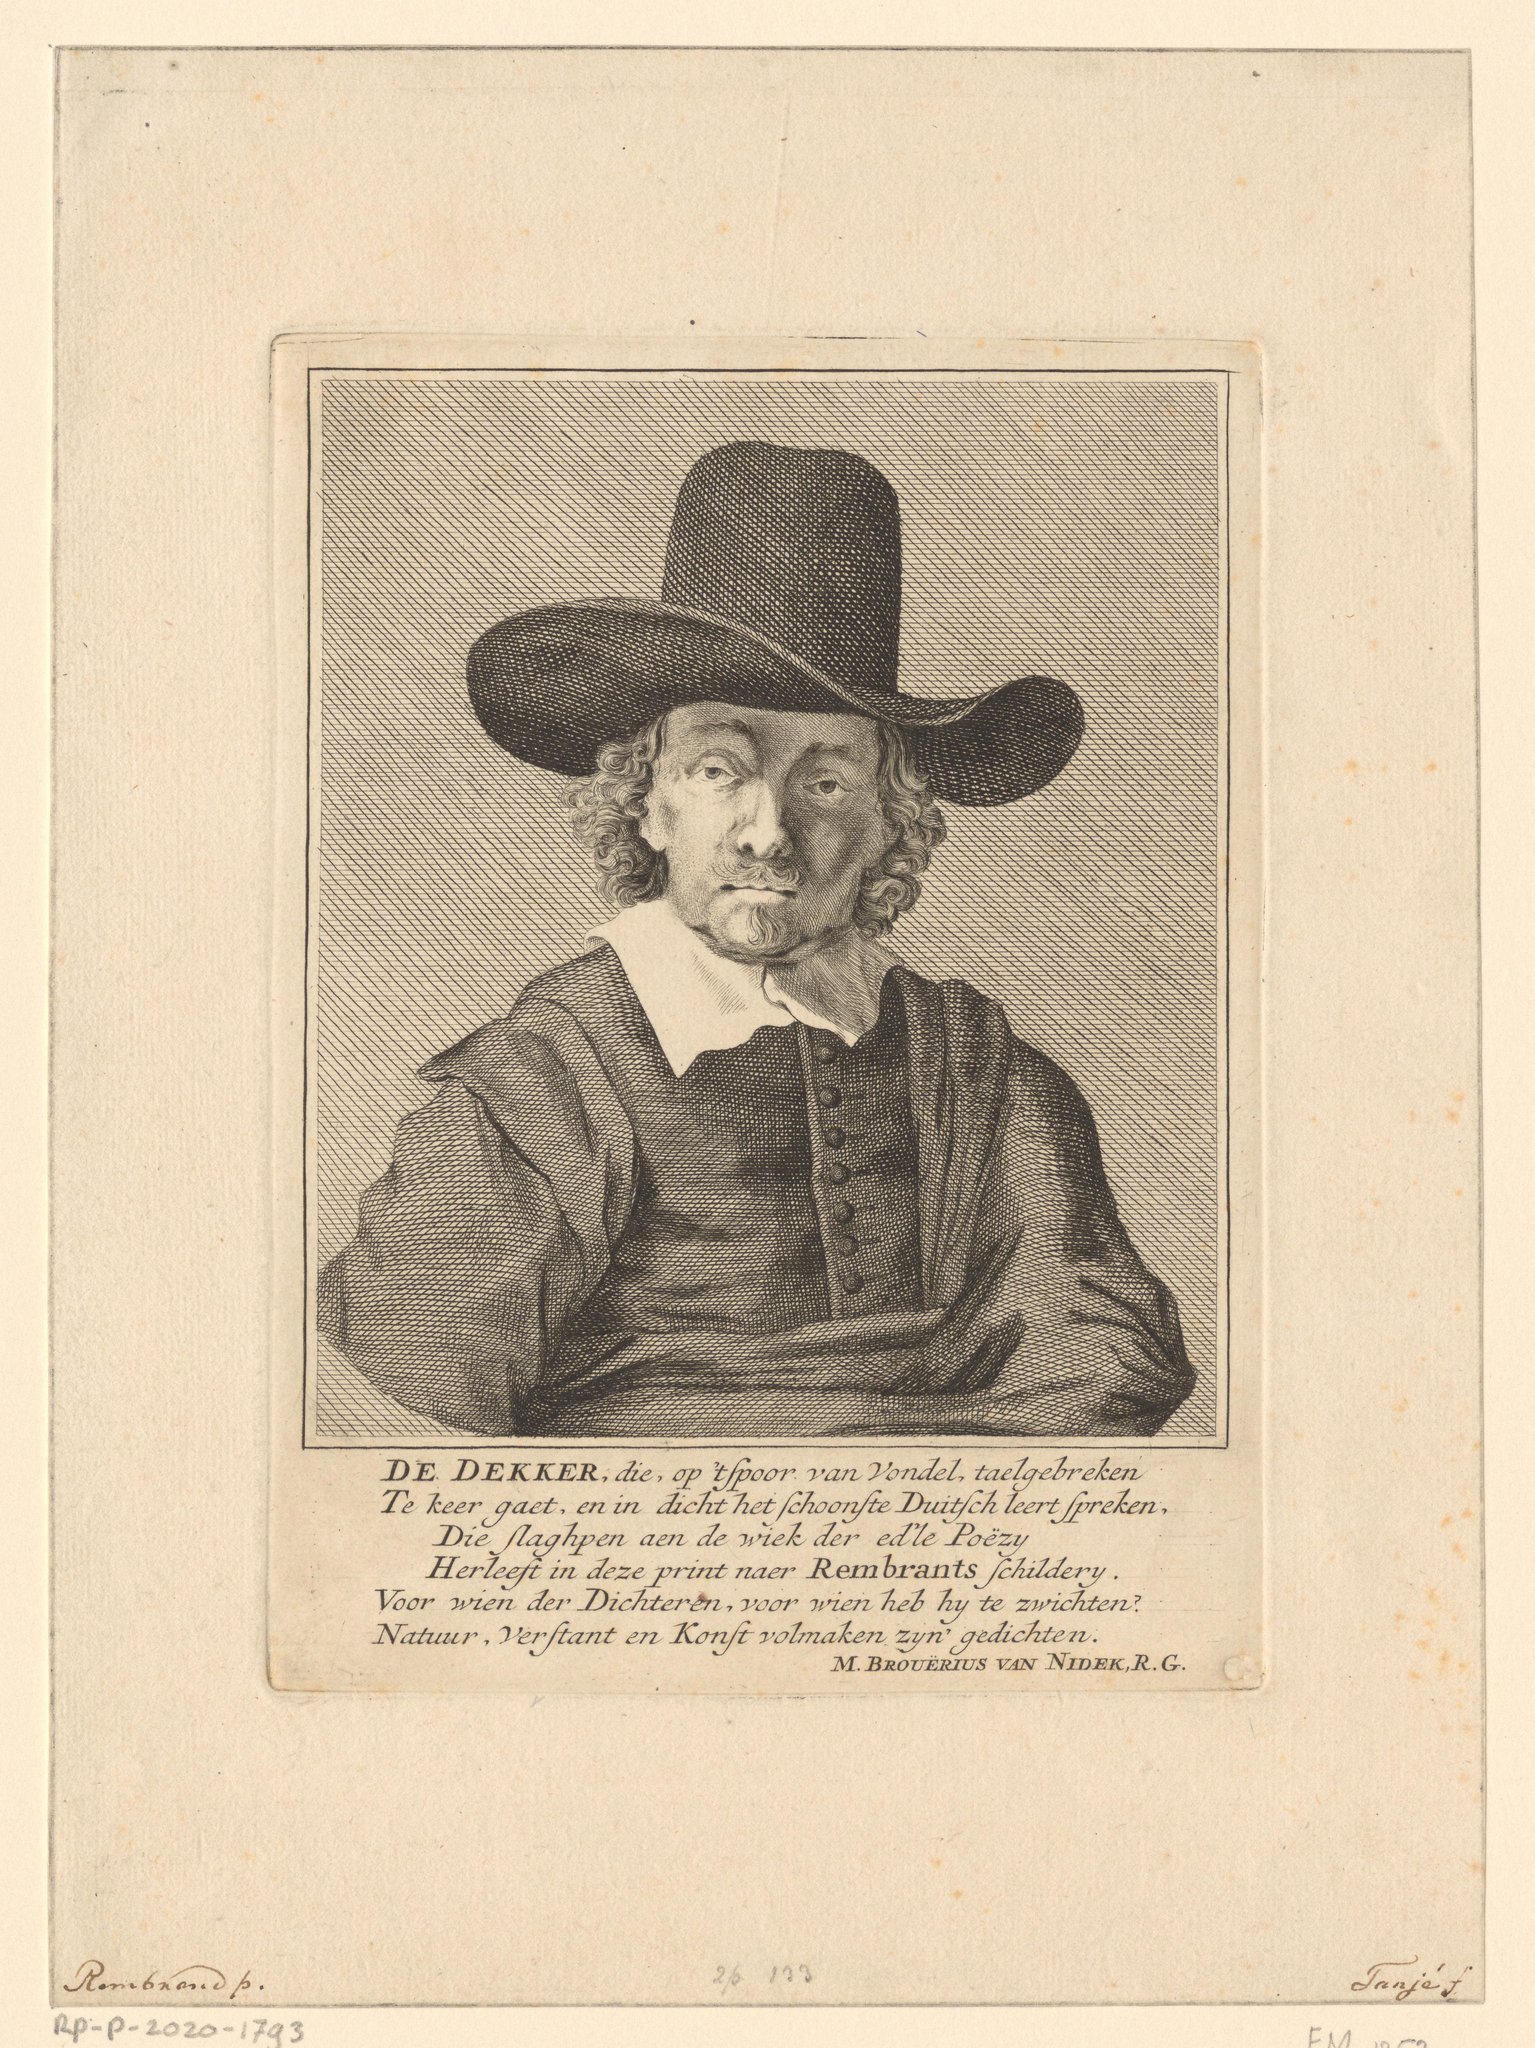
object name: print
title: Portret van Jeremias de Decker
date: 1726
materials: paper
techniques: engraving, etching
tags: jeremias de decker, historical persons, portrait of a writer, head-gear: hat, writer, poet, author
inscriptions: inscription: ‘1272’, inscription: ‘Tanjé f’, check stamp: Lugt 1120, inscription: ‘N. 1609 0. 1666’, inscription: ‘Rembrandt.’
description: Prent waarschijnlijk uit: Decker, Jeremias de, en Matthaeus Brouërius van Nidek. Alle de Rym-oeffeningen (...). Amsterdam: Matthaeus Brouërius van Nidek, 1726, dl. 1.